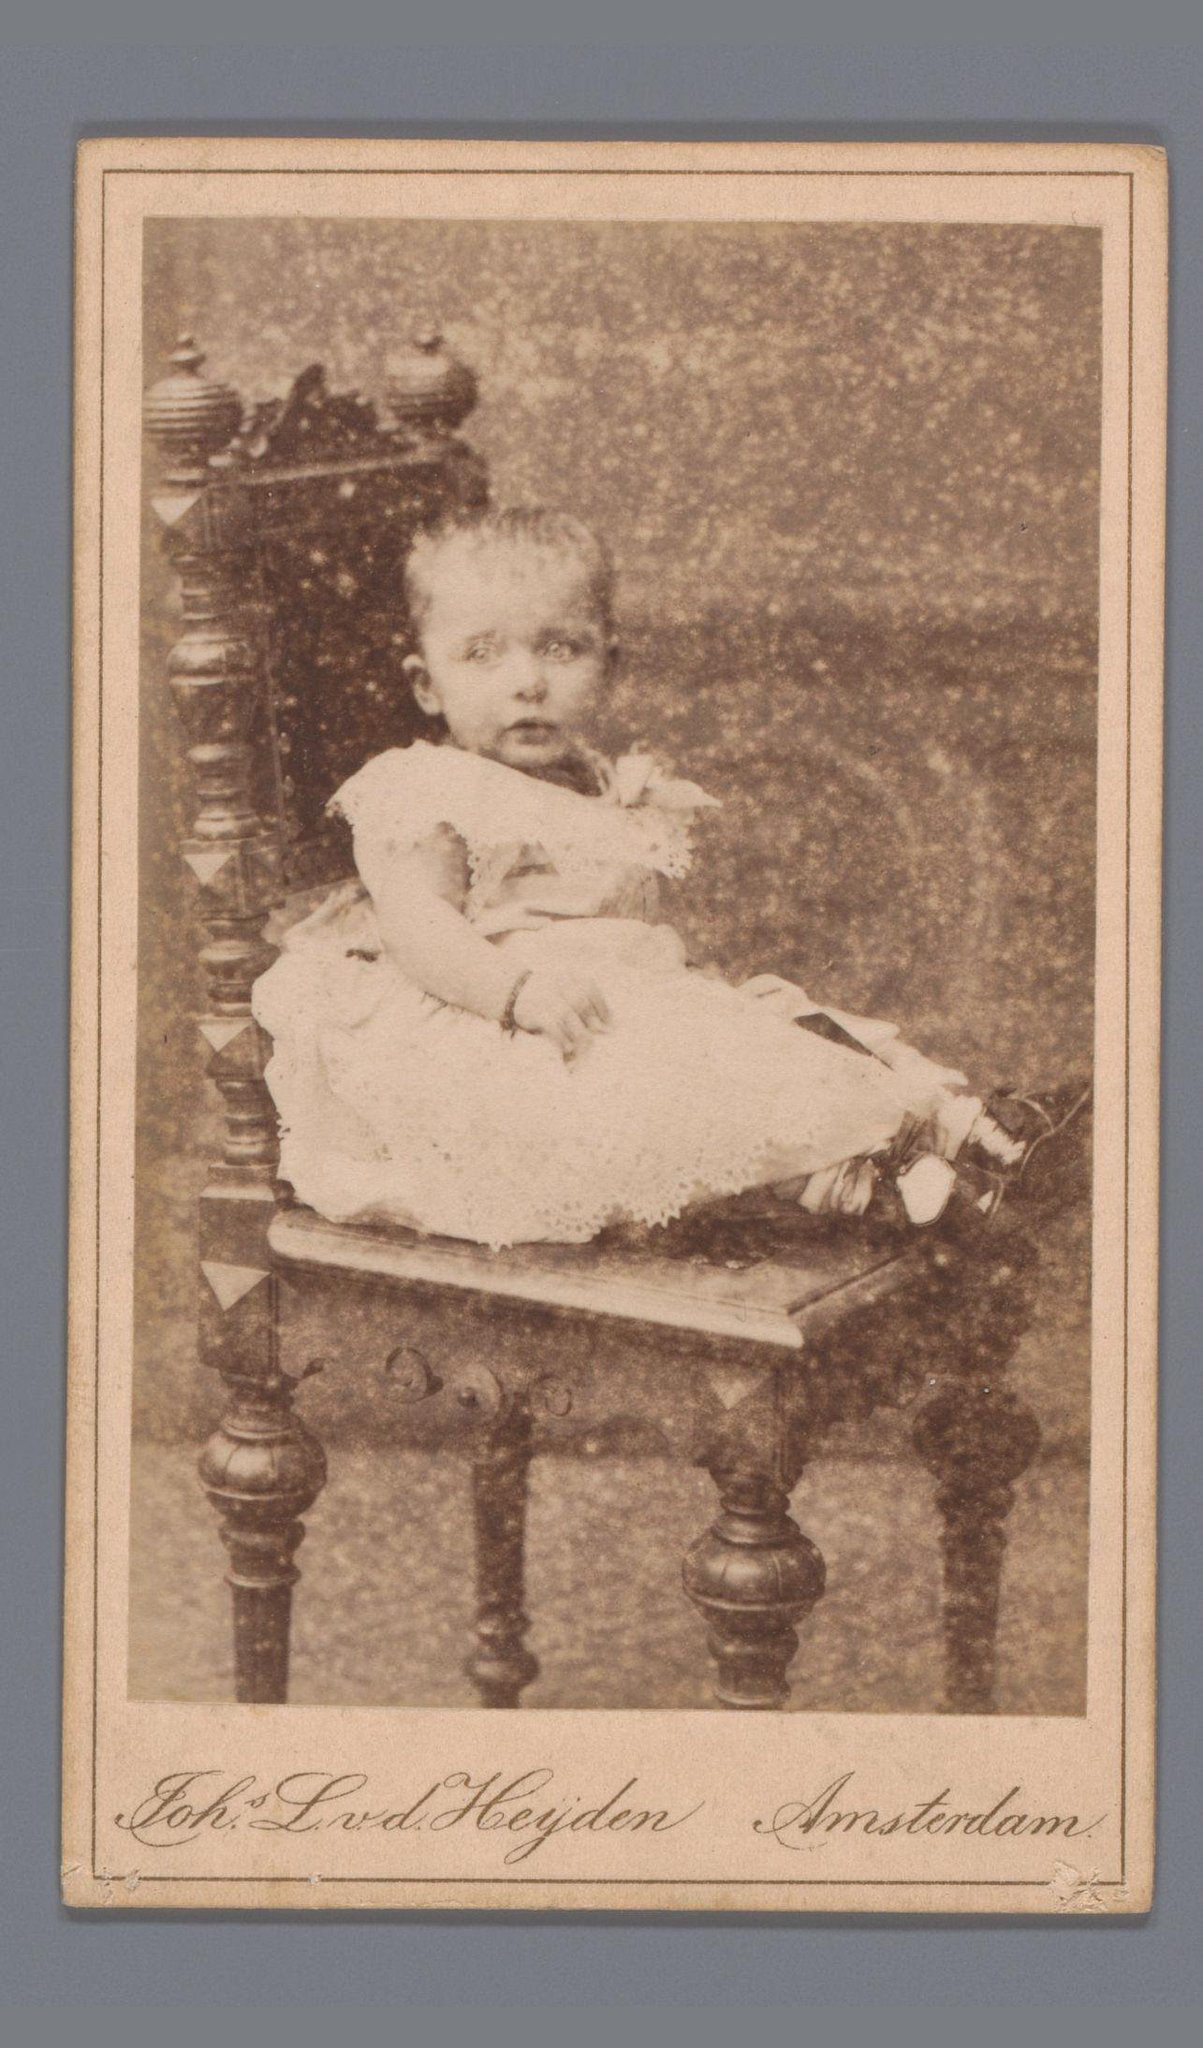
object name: photograph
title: Portret van een onbekend kind, zittend op een stoel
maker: johannes leonardus van der heijden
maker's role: fotograaf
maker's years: 1856-1937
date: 1875-1900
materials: cardboard, paper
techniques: albumen print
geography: amsterdam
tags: child, historical persons, chair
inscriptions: inscription: ‘PHOTOGRAPHIE ARTISTIQUE/ Johs L. van der Heijden/ Amsterdam/ Heiligenweg hoek Singel 435./ SPECIALITEIT IN ONVERANDERLIJKE/ VERGROOTINGEN.’